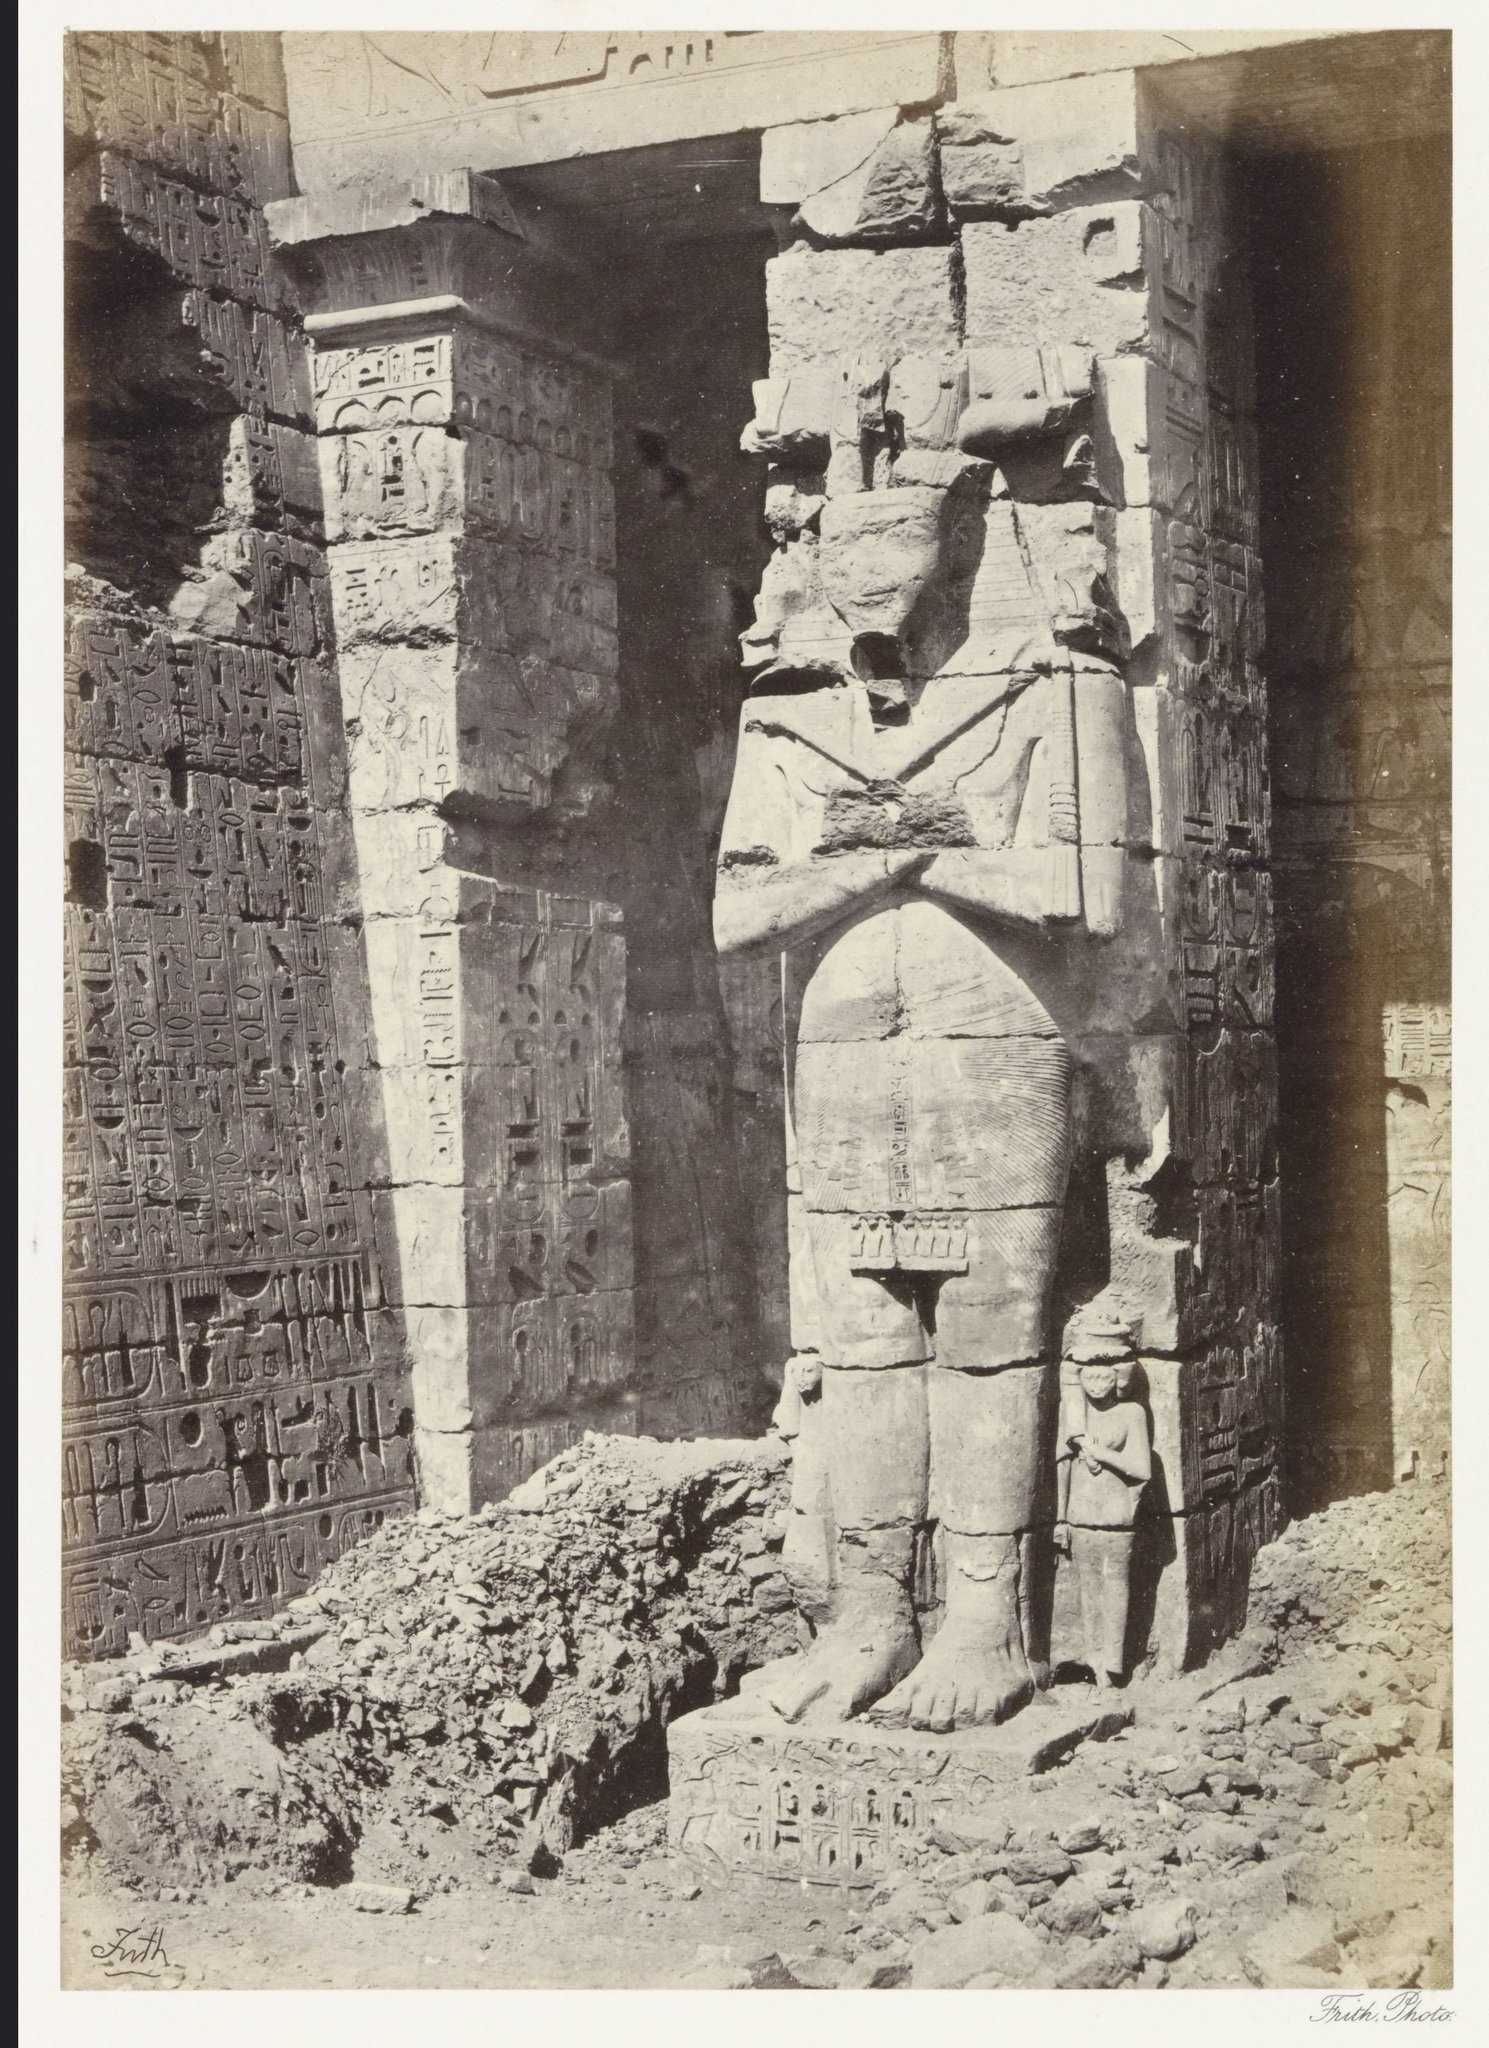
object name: page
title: Osiride pillars at Medinet-Haboo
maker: francis frith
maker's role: publisher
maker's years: 1822-1898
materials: paper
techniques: albumen print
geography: medinet habu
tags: temple, shrine ~ egyptian religion, column, pillar ~ architecture